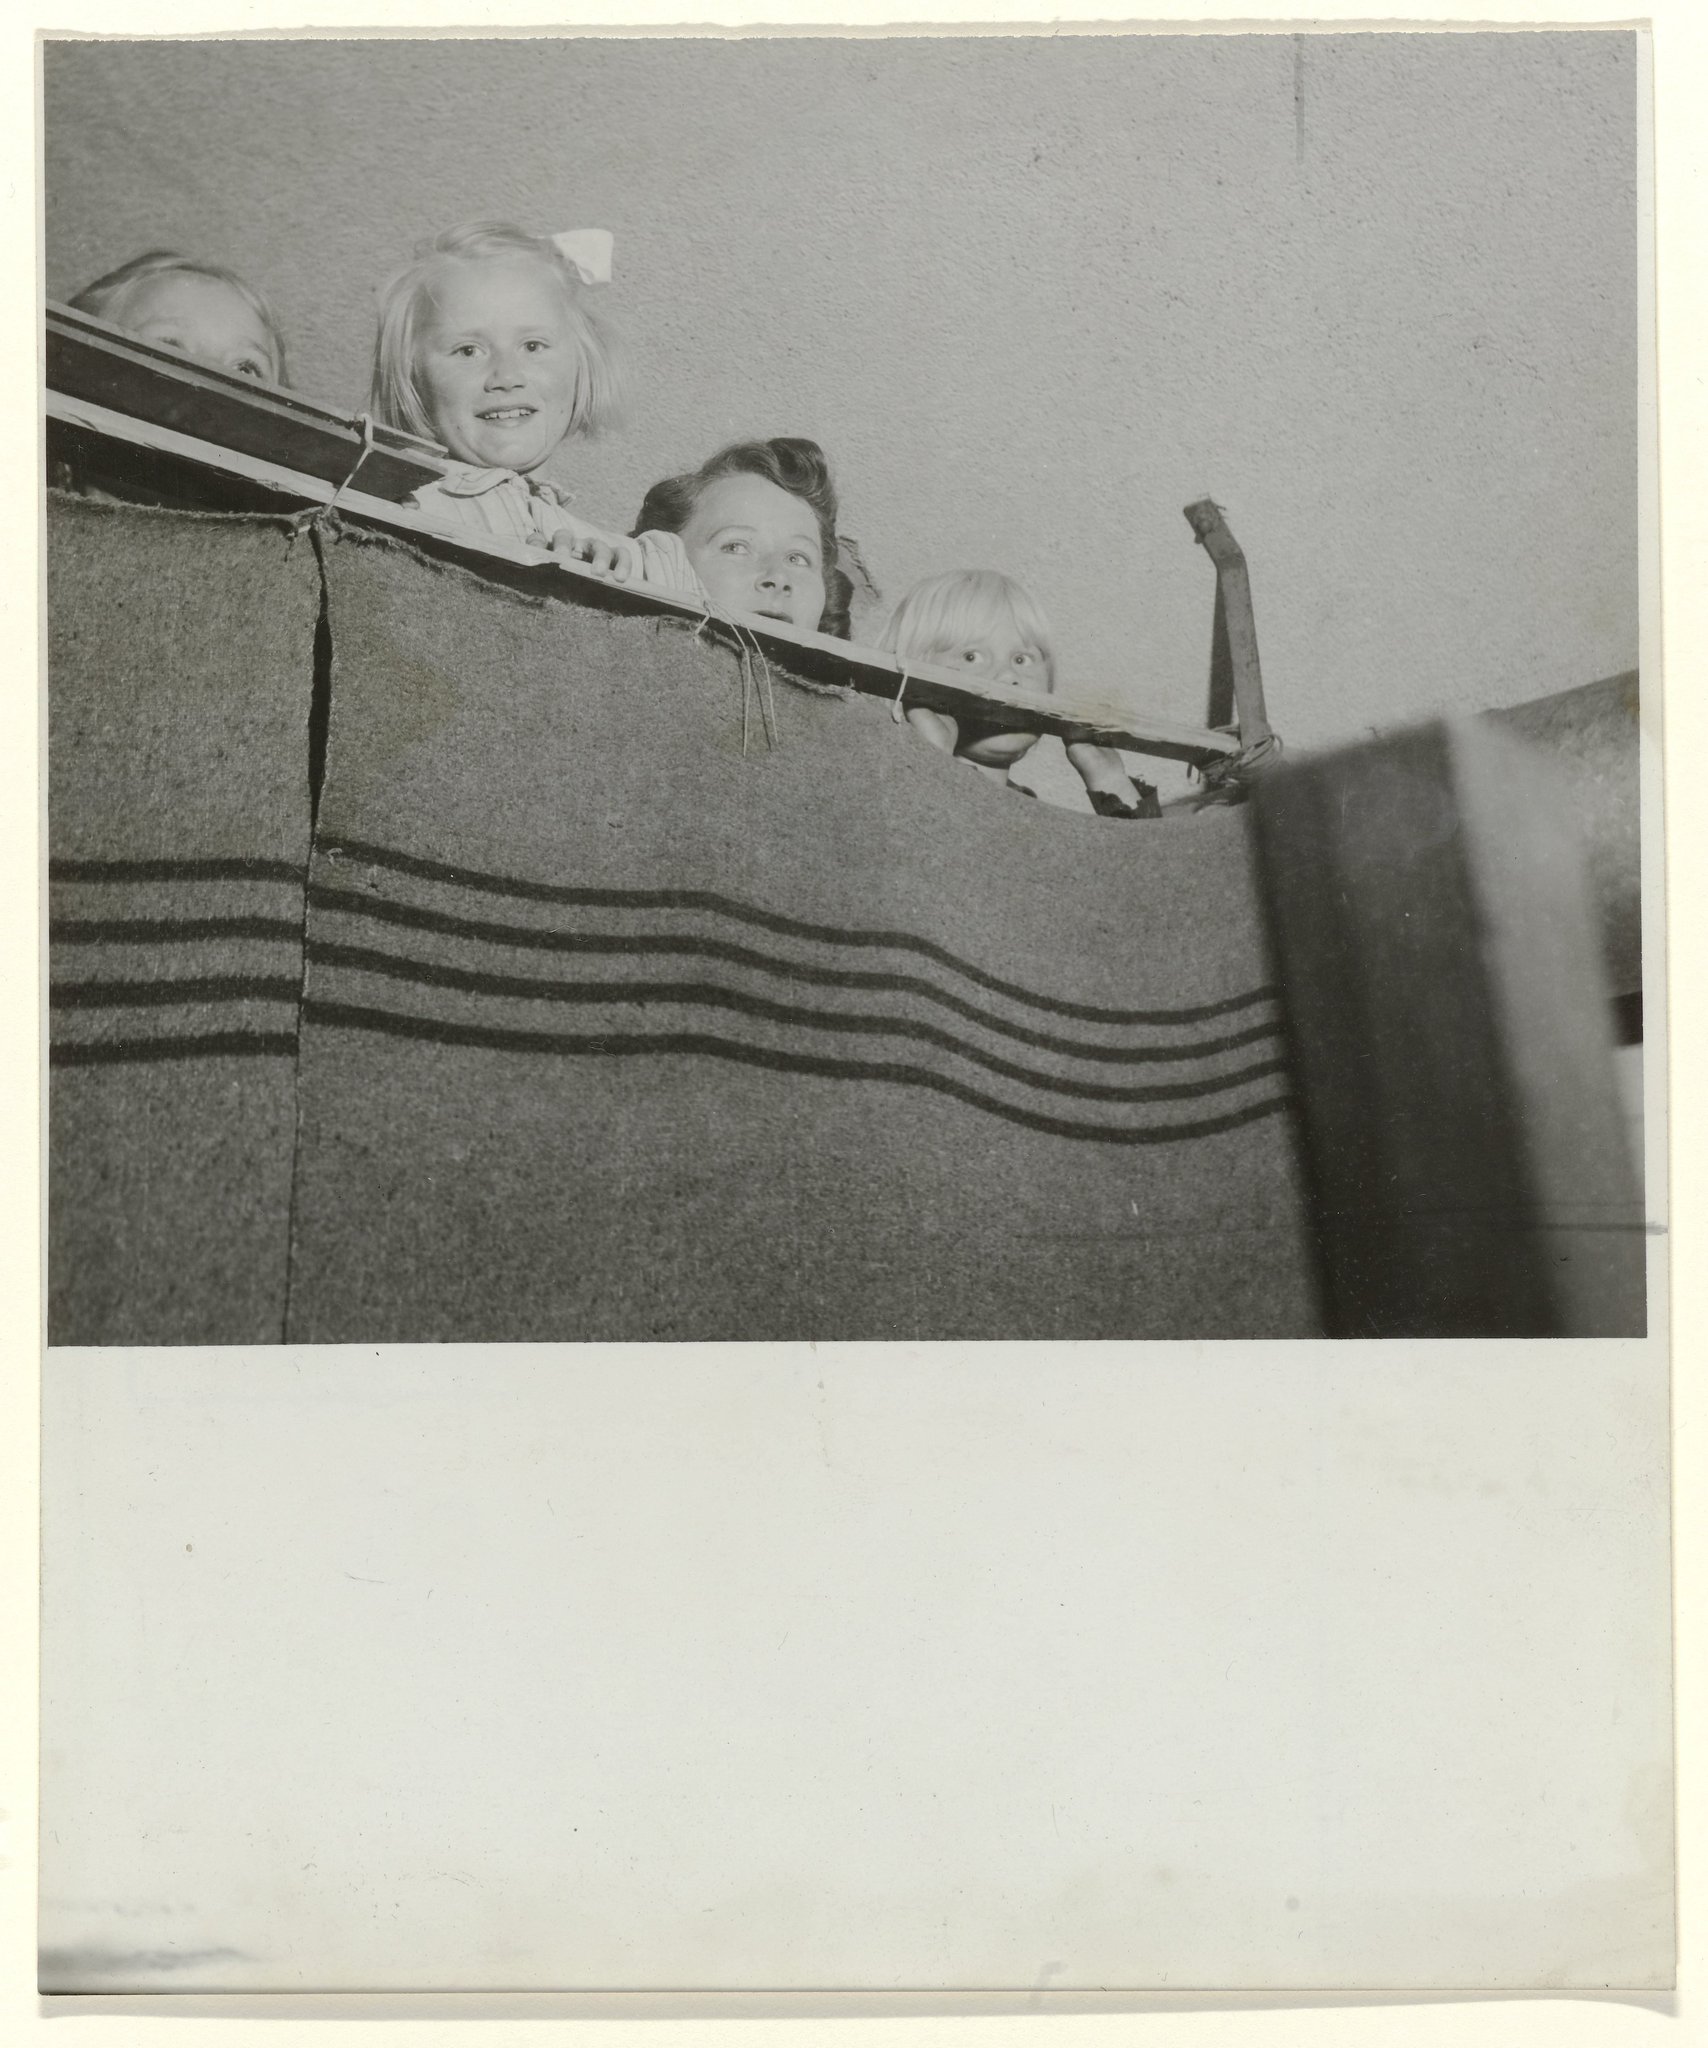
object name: documentary photograph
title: Een familie achter een deken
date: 1945-1947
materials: photographic support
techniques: photography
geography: netherlands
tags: netherlands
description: Drie kinderen en hun moeder kijken over een oude deken heen, die is opgehangen met een paar touwtjes.